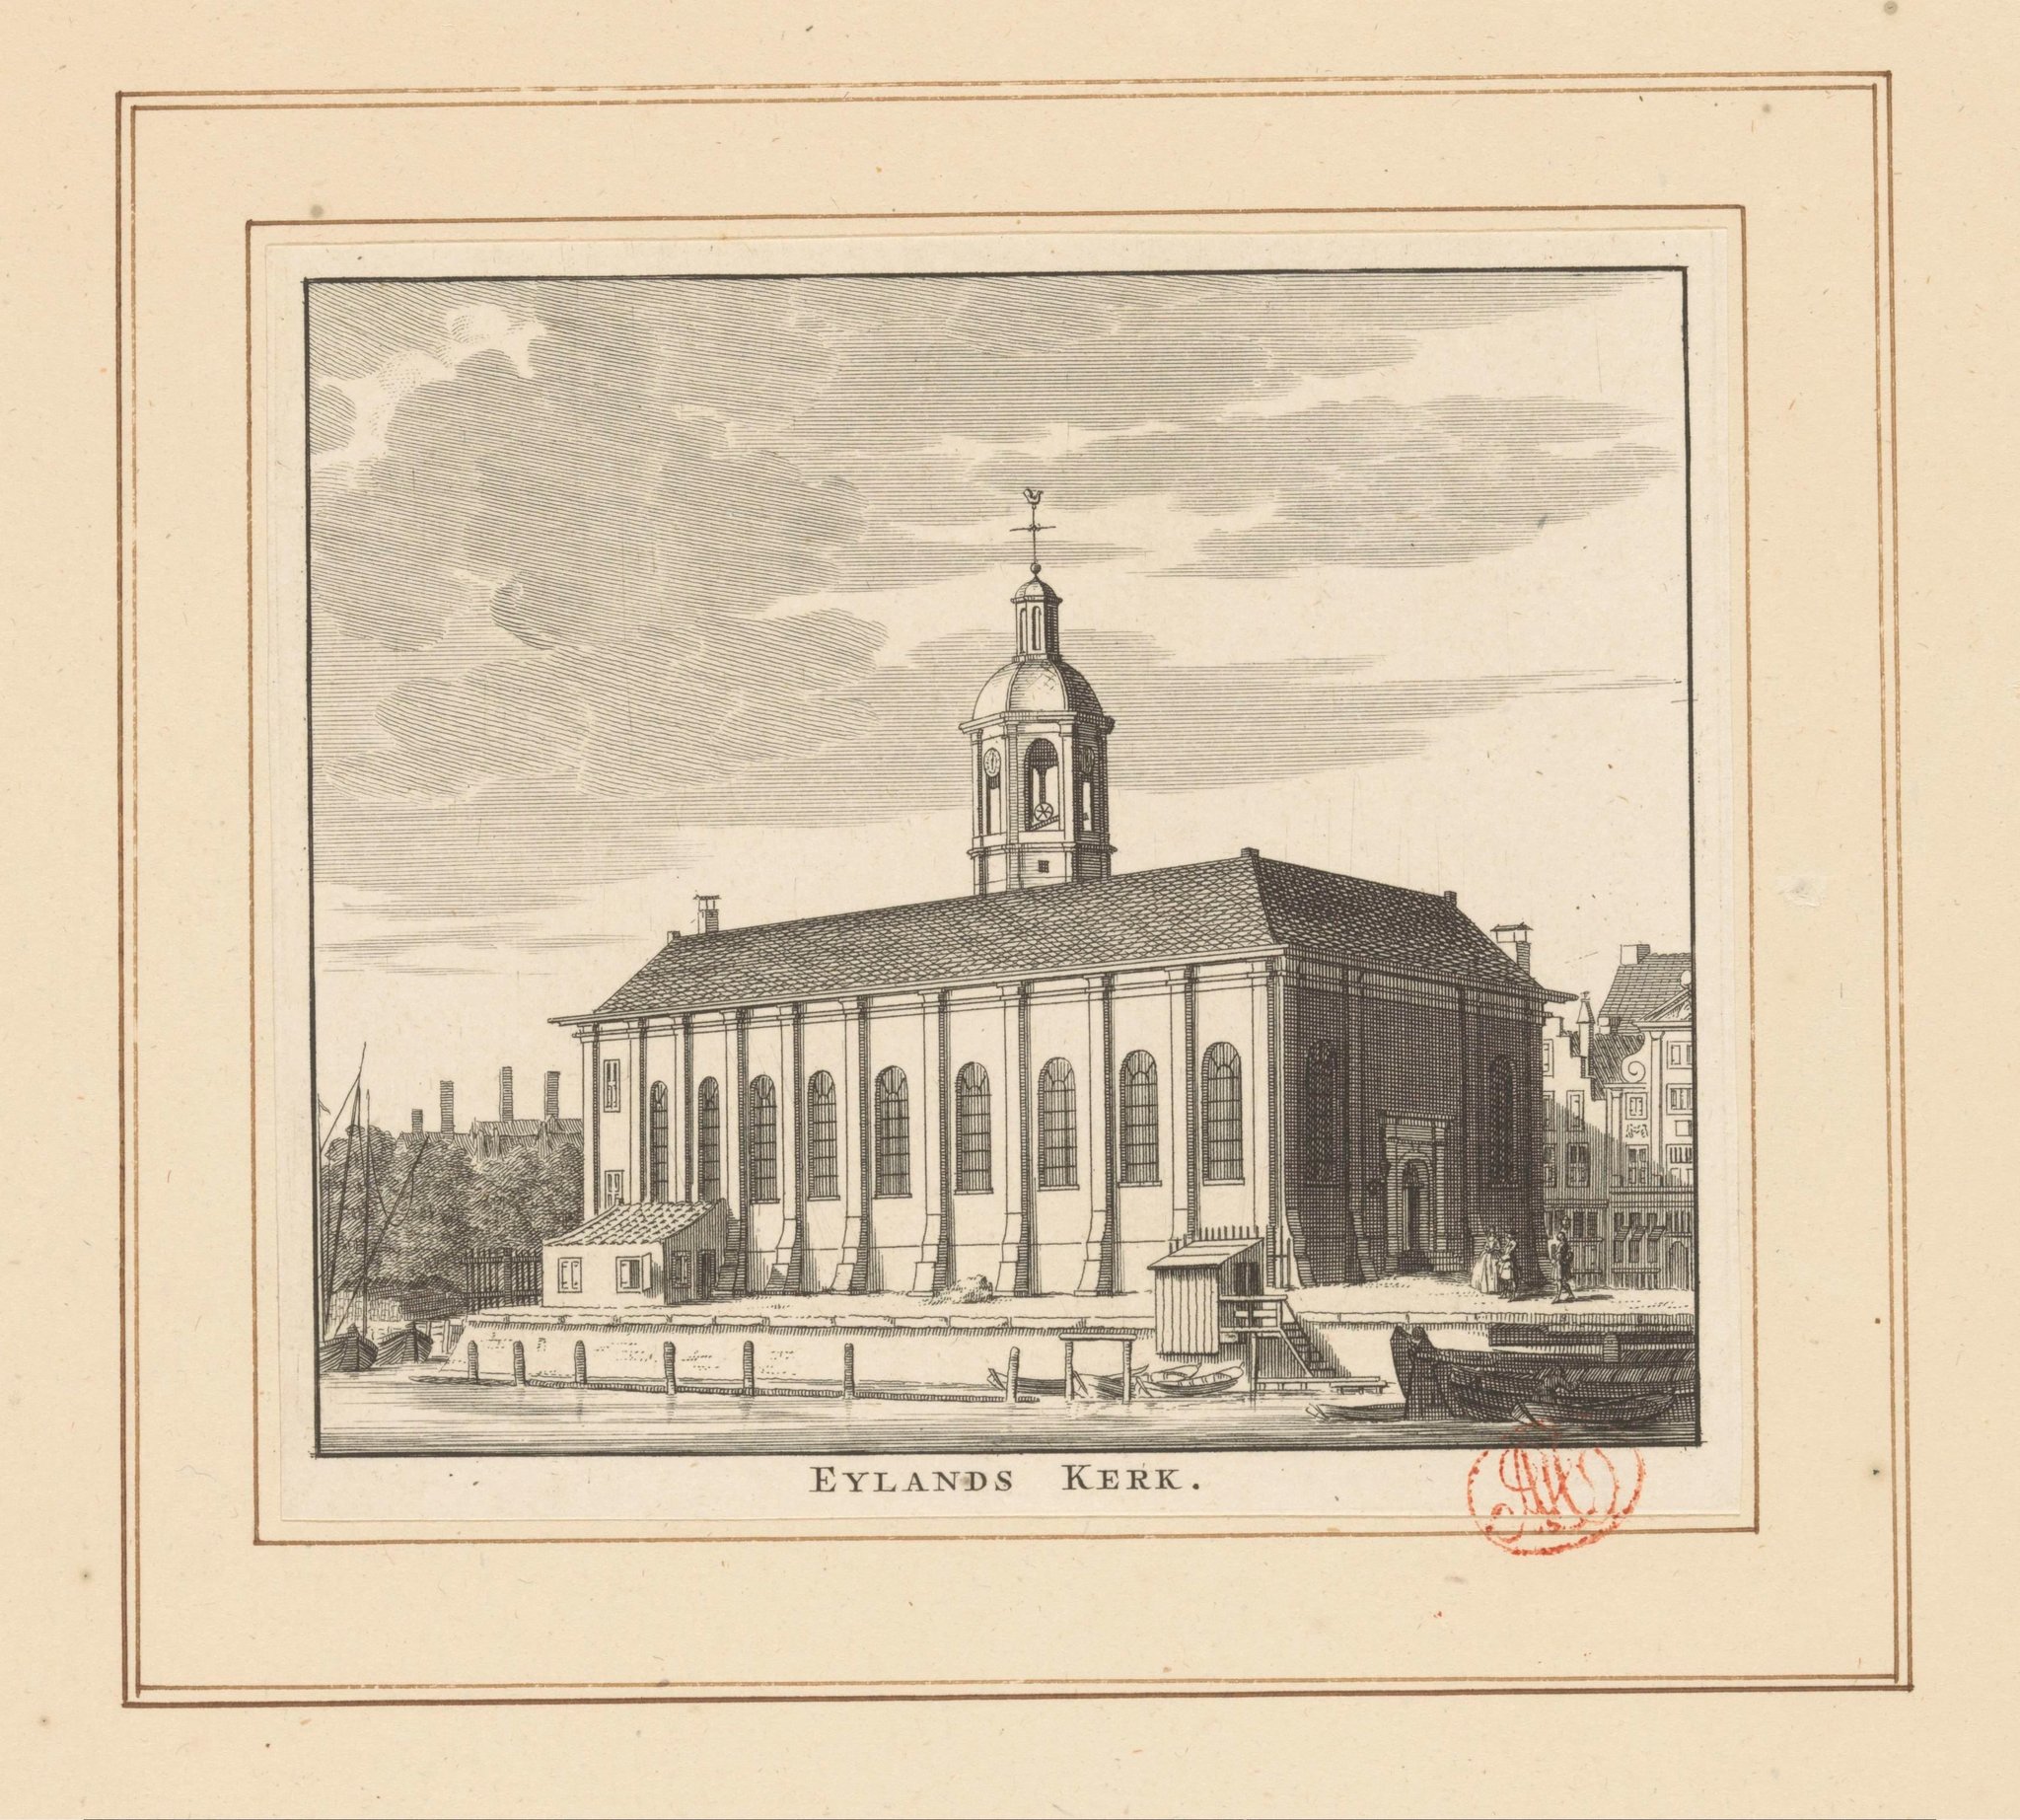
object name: print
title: Eylands Kerk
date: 1765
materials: paper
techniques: engraving, etching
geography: amsterdam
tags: church (exterior)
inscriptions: collector's mark: Lugt 195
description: Prent ook gebruikt in: Wagenaar, Jan. Amsterdam, in zyne opkomst, aanwas, geschiedenissen (…). 3 delen [folio-uitgave]. Amsterdam: Isaak Tirion en Yntema & Tieboel, 1760-1767, dl. 2 (Isaac Tirion, 1765).